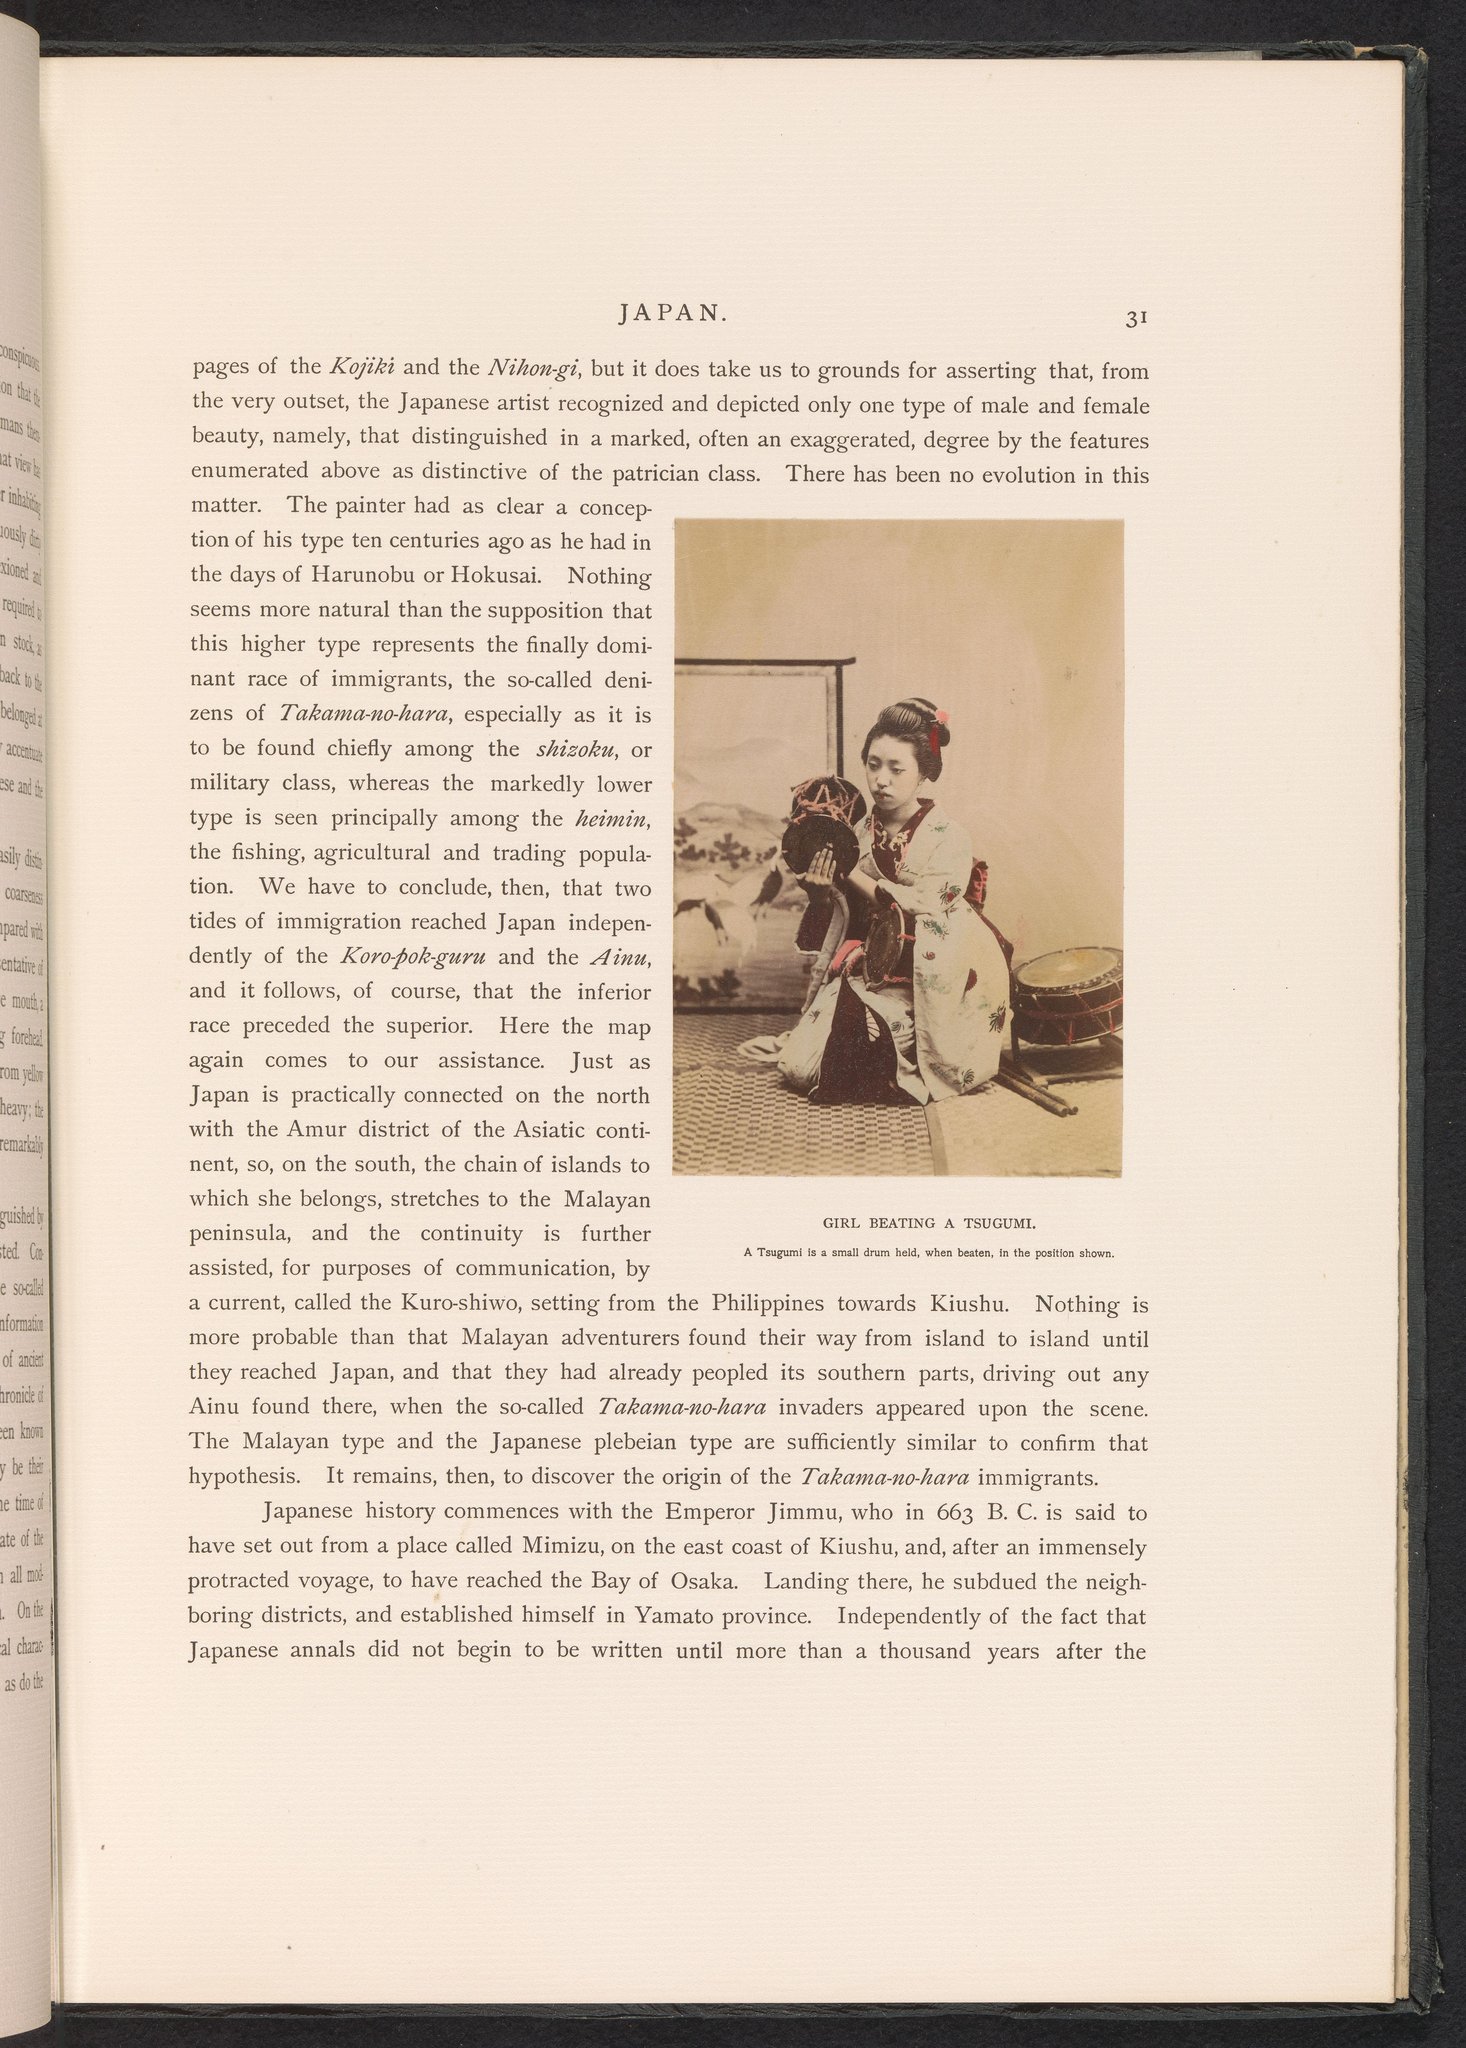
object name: photograph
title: Girl beating a tsugumi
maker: Anonymous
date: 1887-1897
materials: photographic support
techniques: albumen print, hand coloring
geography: japan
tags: adolescent, young woman, maiden, drum (musical instrument), folk costume, regional costume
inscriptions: inscription: ‘A Tsugumi is a small drum held, when beaten, in the position shown.’